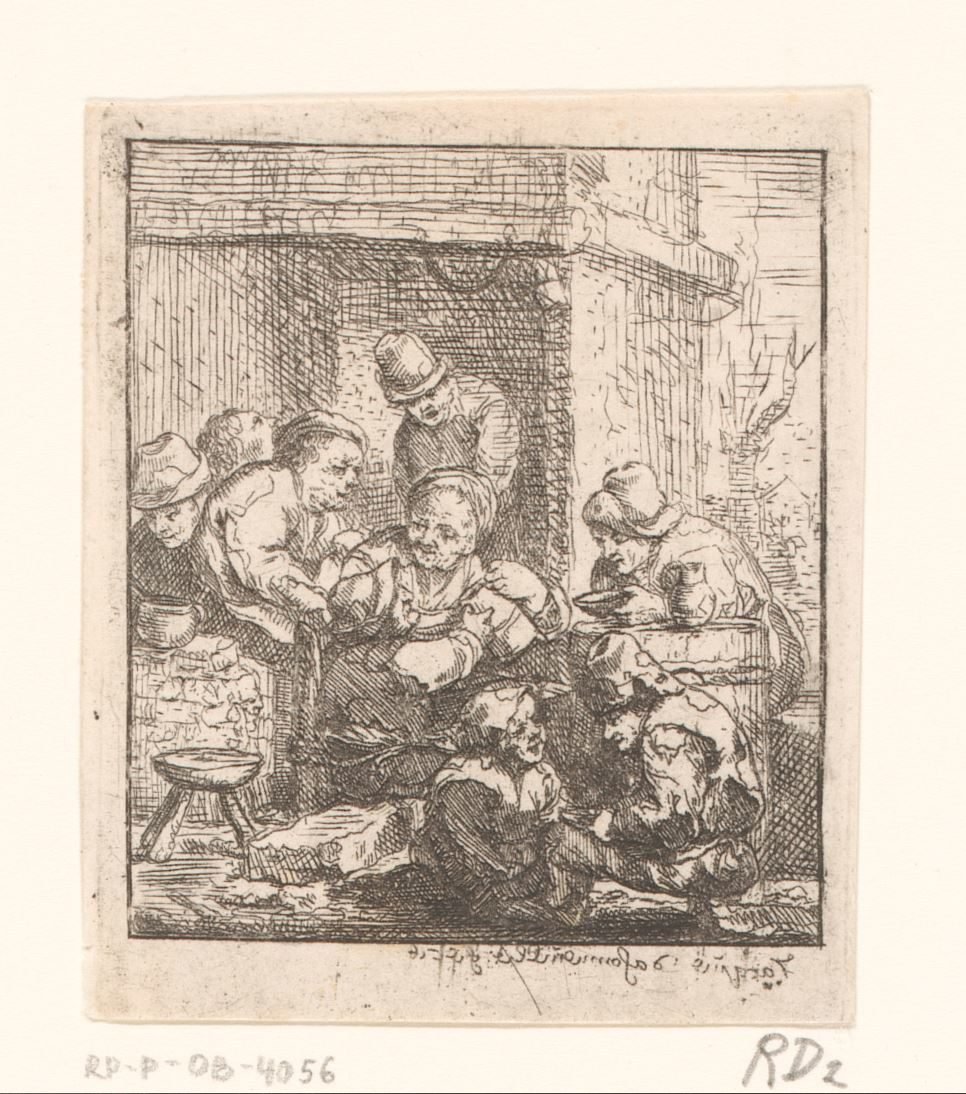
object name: print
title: Drinkend gezelschap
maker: jacques dassonville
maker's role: print maker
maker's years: 1619-1670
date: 1629-1670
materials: paper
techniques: engraving, etching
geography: france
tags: beer, ale, drinking, private festivities, merry company